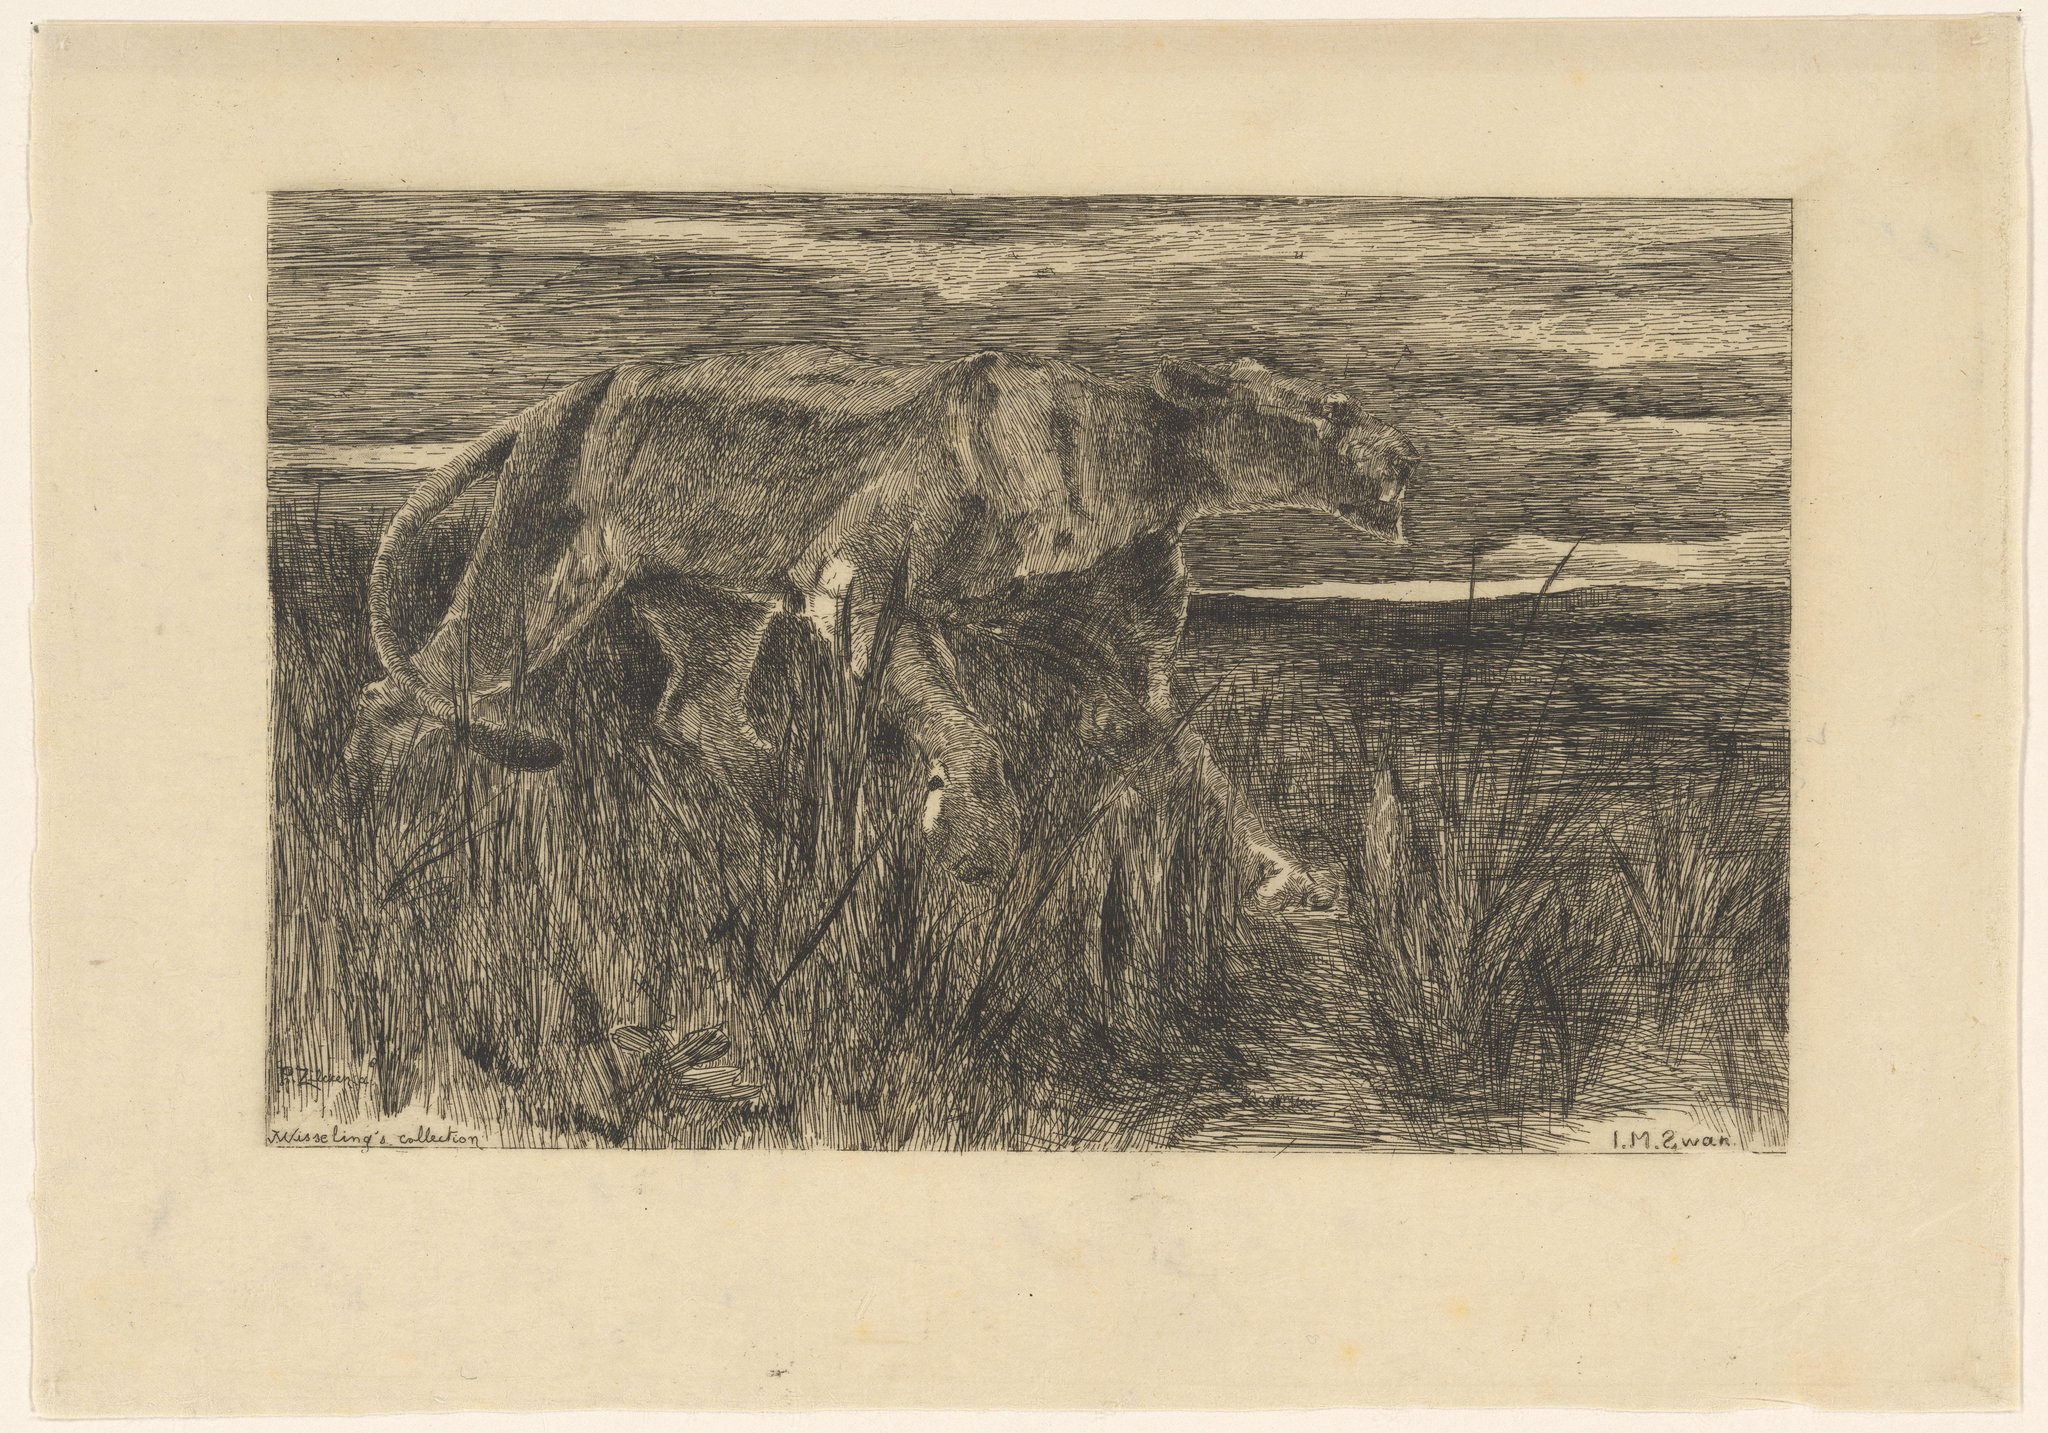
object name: print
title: Leeuwin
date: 1867-1890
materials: paper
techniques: etching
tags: beasts of prey, predatory animals: lion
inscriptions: collector's mark: Lugt 2233, annotation: ‘Wisseling's collection’